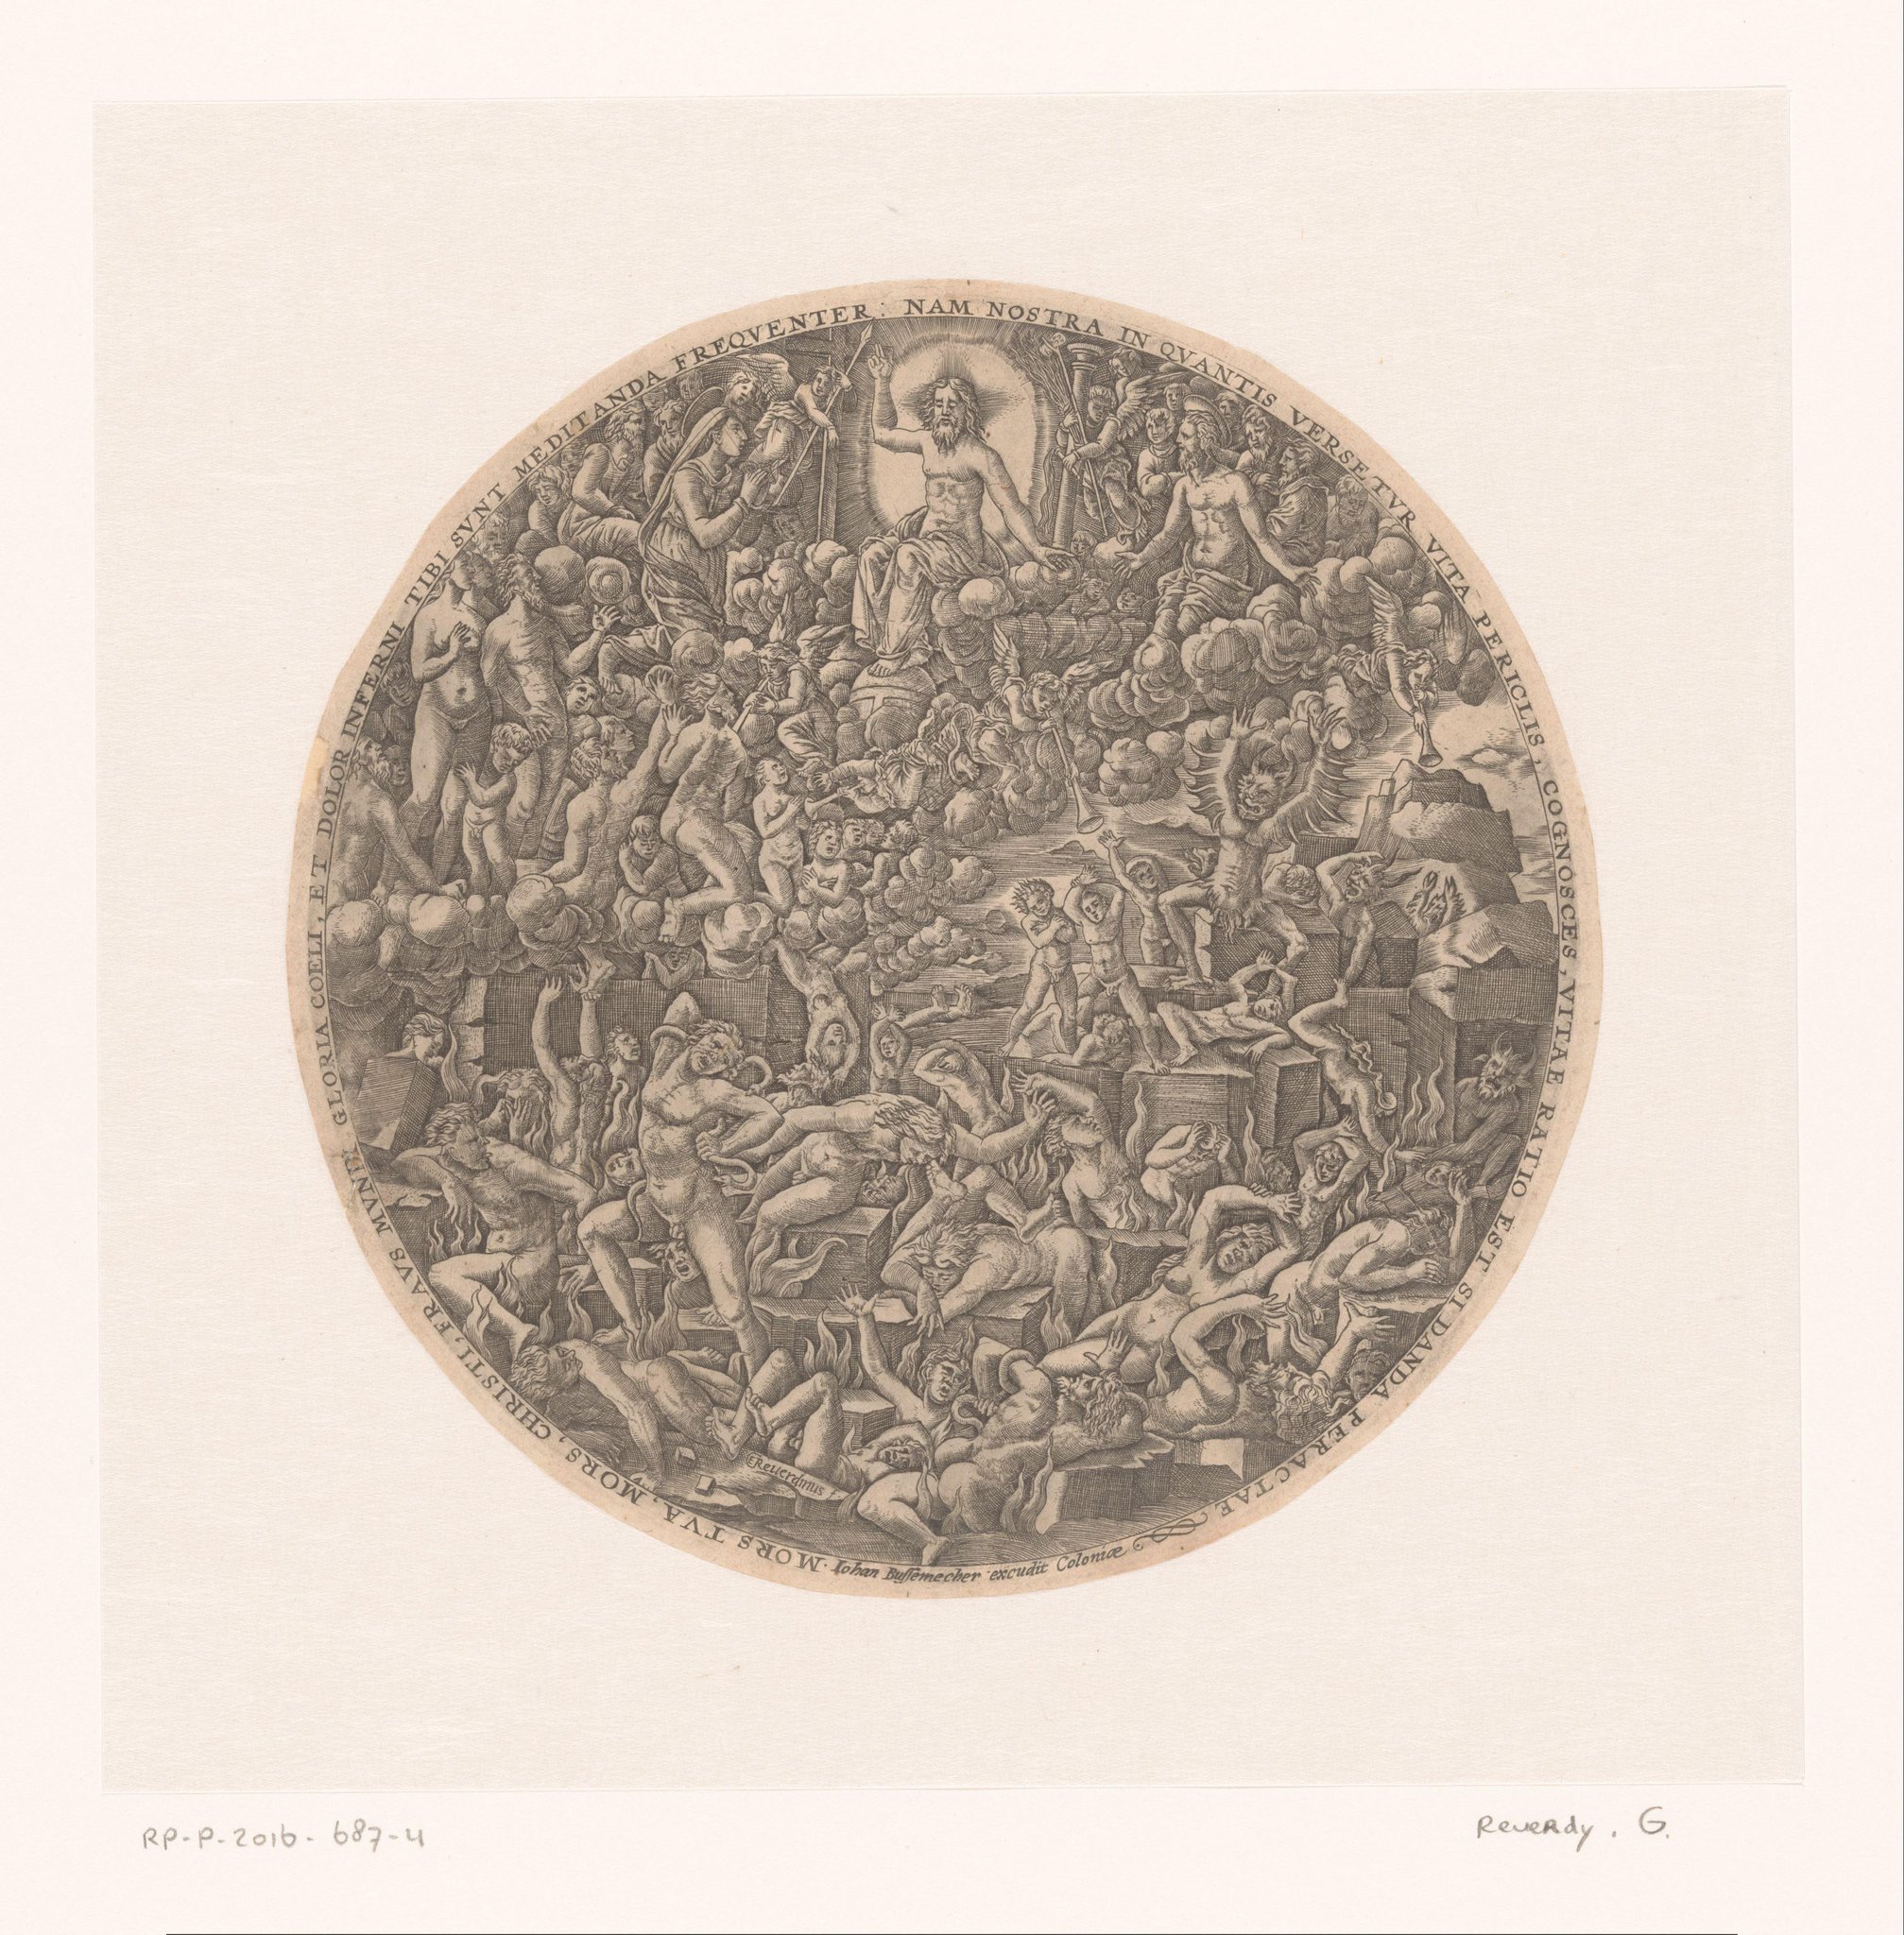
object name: print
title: Laatste Oordeel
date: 1550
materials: paper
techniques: engraving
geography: cologne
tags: comprehensive representation of last judgement: christ (with sword and lily), often surrounded by elders and sometimes accompanied by mary and john the baptist, appears in the sky with trumpeting angels (and sometimes angels holding the instruments of the passion); after the resurrection of the dead the blessed are led to heaven by angels, and the damned are dragged into hell by devils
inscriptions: collector's mark: Lugt 2228, collector's mark: Lugt 2760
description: De figuren zijn gebaseerd op prenten naar antieke voorbeelden, bijvoorbeeld de Laocoöngroep.